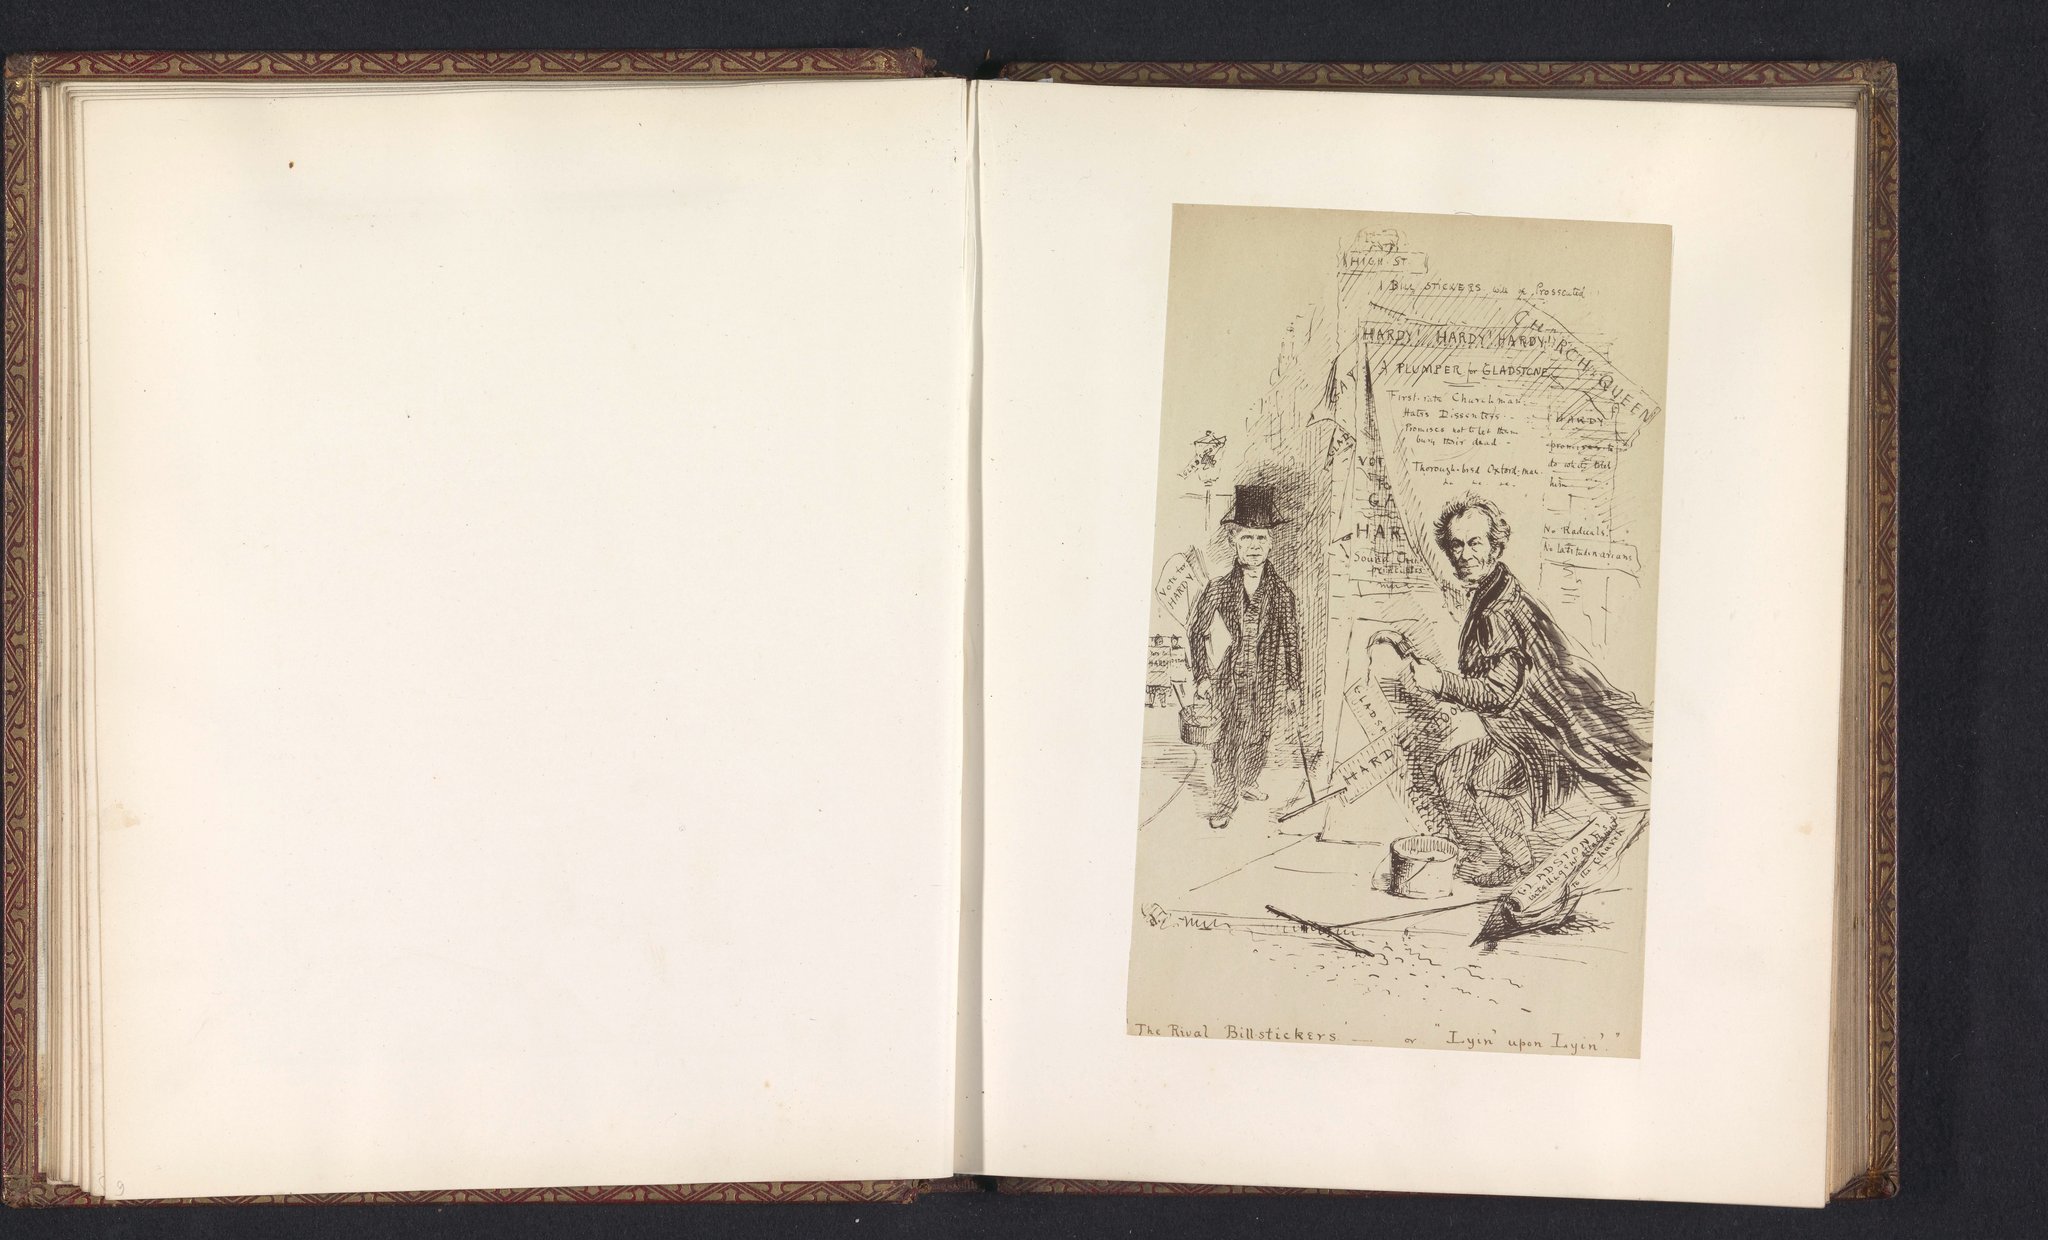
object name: reproduction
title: Fotoreproductie van een tekening, voorstellende professor Jacobson en aartsdiaken Clerke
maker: Anonymous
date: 1855-1866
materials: photographic support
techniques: albumen print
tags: political campaign, deacon (roman catholic)